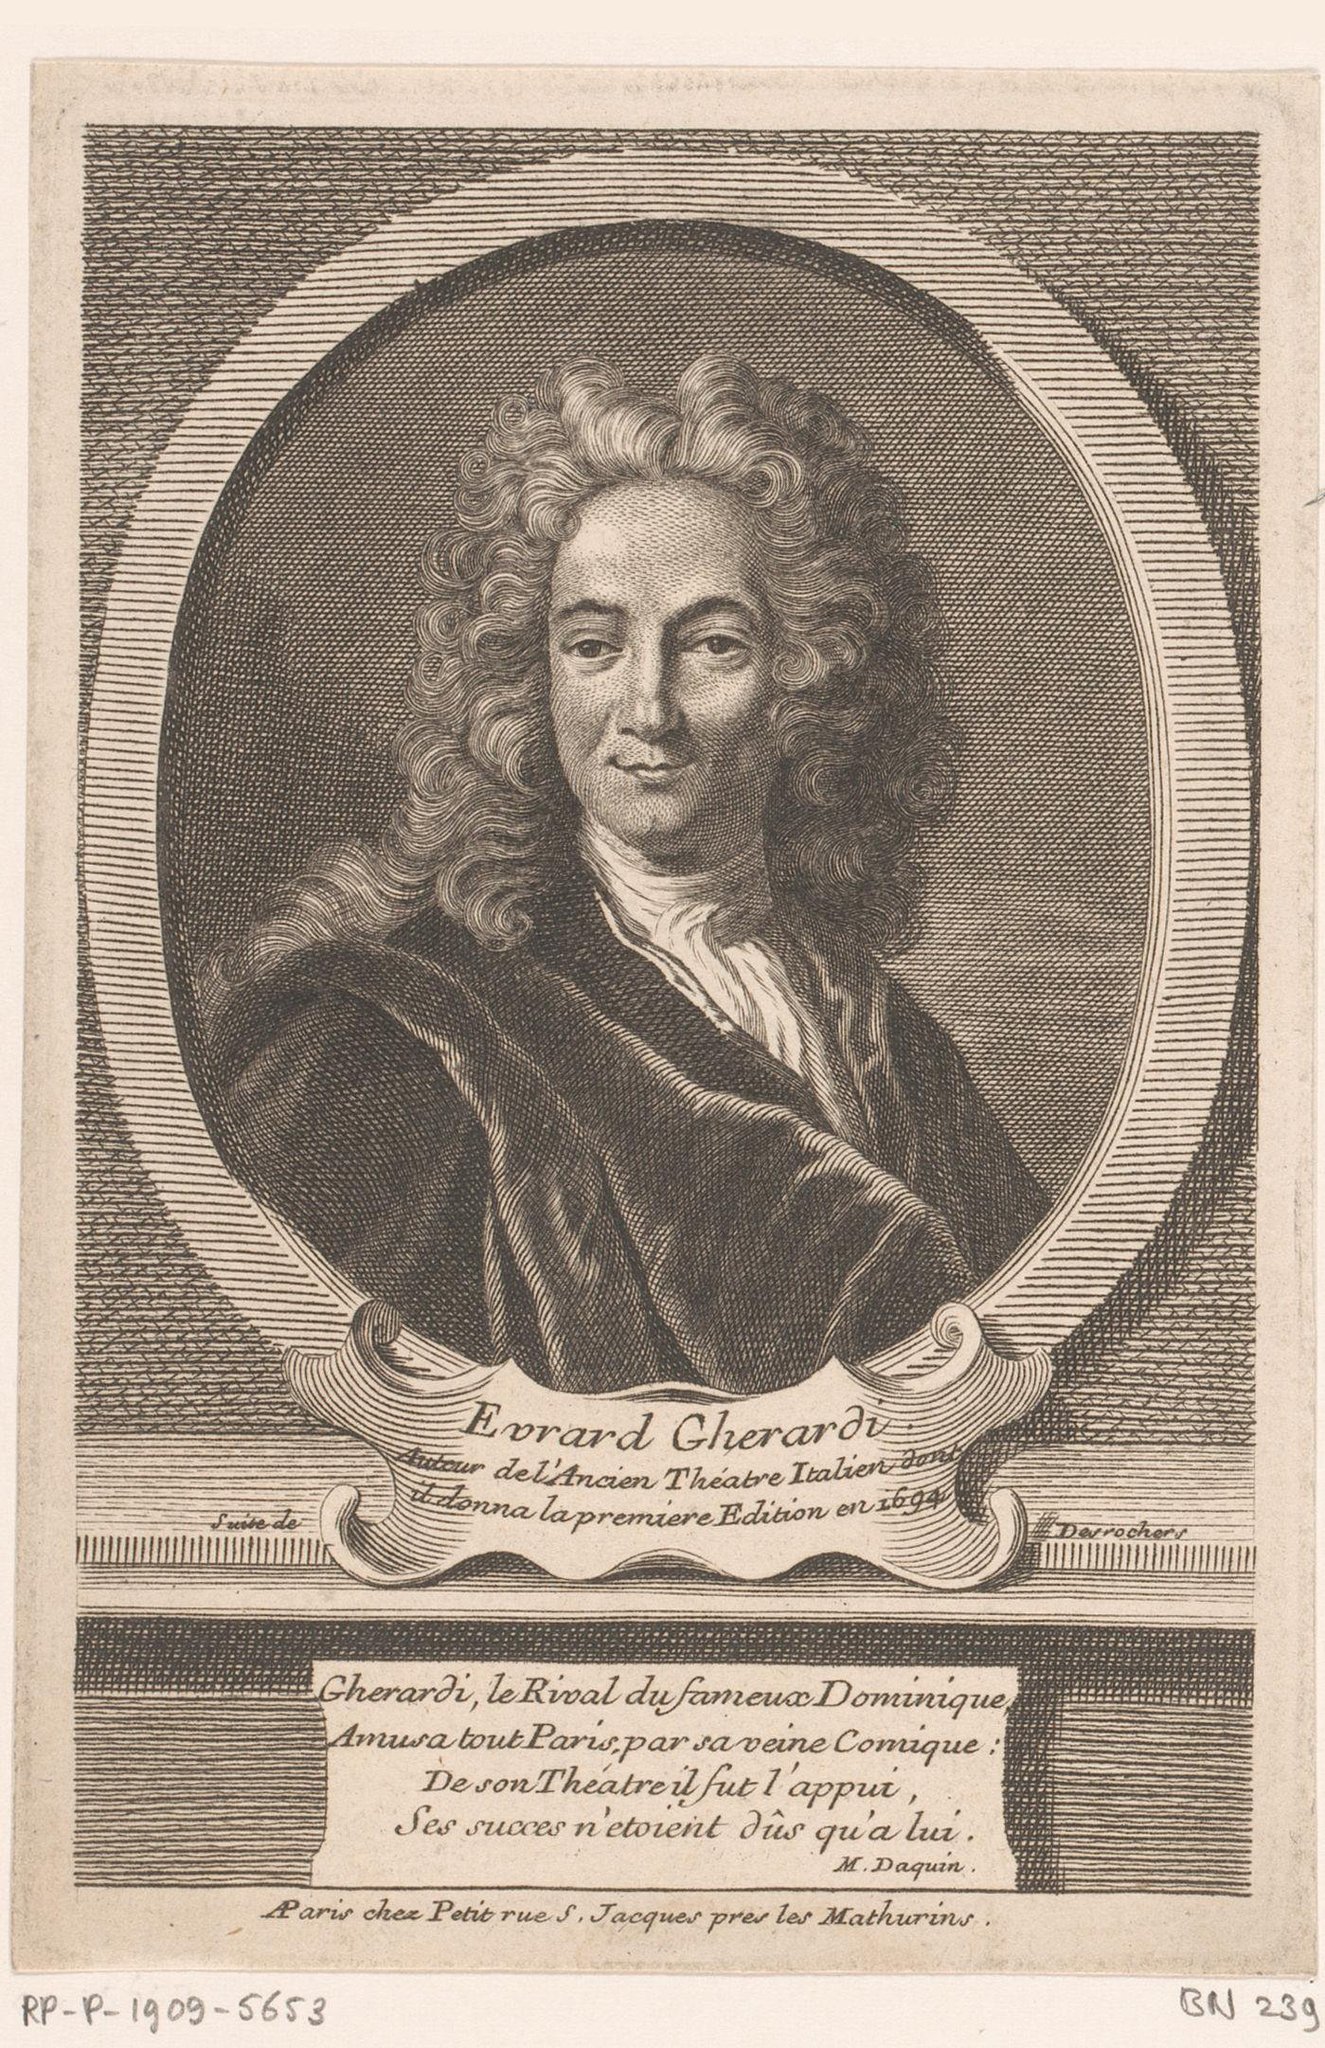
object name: print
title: Recueil de portraits (...)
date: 1726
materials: paper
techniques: engraving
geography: paris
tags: paris, historical persons, portrait of a writer, portrait of actor, actress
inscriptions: collector's mark: Lugt 2228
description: Behoort waarschijnlijk tot een serie portretten, grotendeels door Etienne Desrochers, getiteld: 'Recueil de portraits de personnes qui se sont distinguées tant dans les Armes que dans Belles-Lettres et les Arts, comme aussi la famille royale de France et autres cours étrangères'. De serie werd initieel uitgegeven door Desrochers en aangekondigd in 'Mercure' in mei 1726, p. 985. Echter was Desrochers reeds enkele jaren eerder begonnen met het uitgeven van de serie. Na de dood van Desrochers werd de serie voortgezet door Gilles Edme Petit. Een latere staat werd uitgegeven door Jean François Daumont in Parijs.